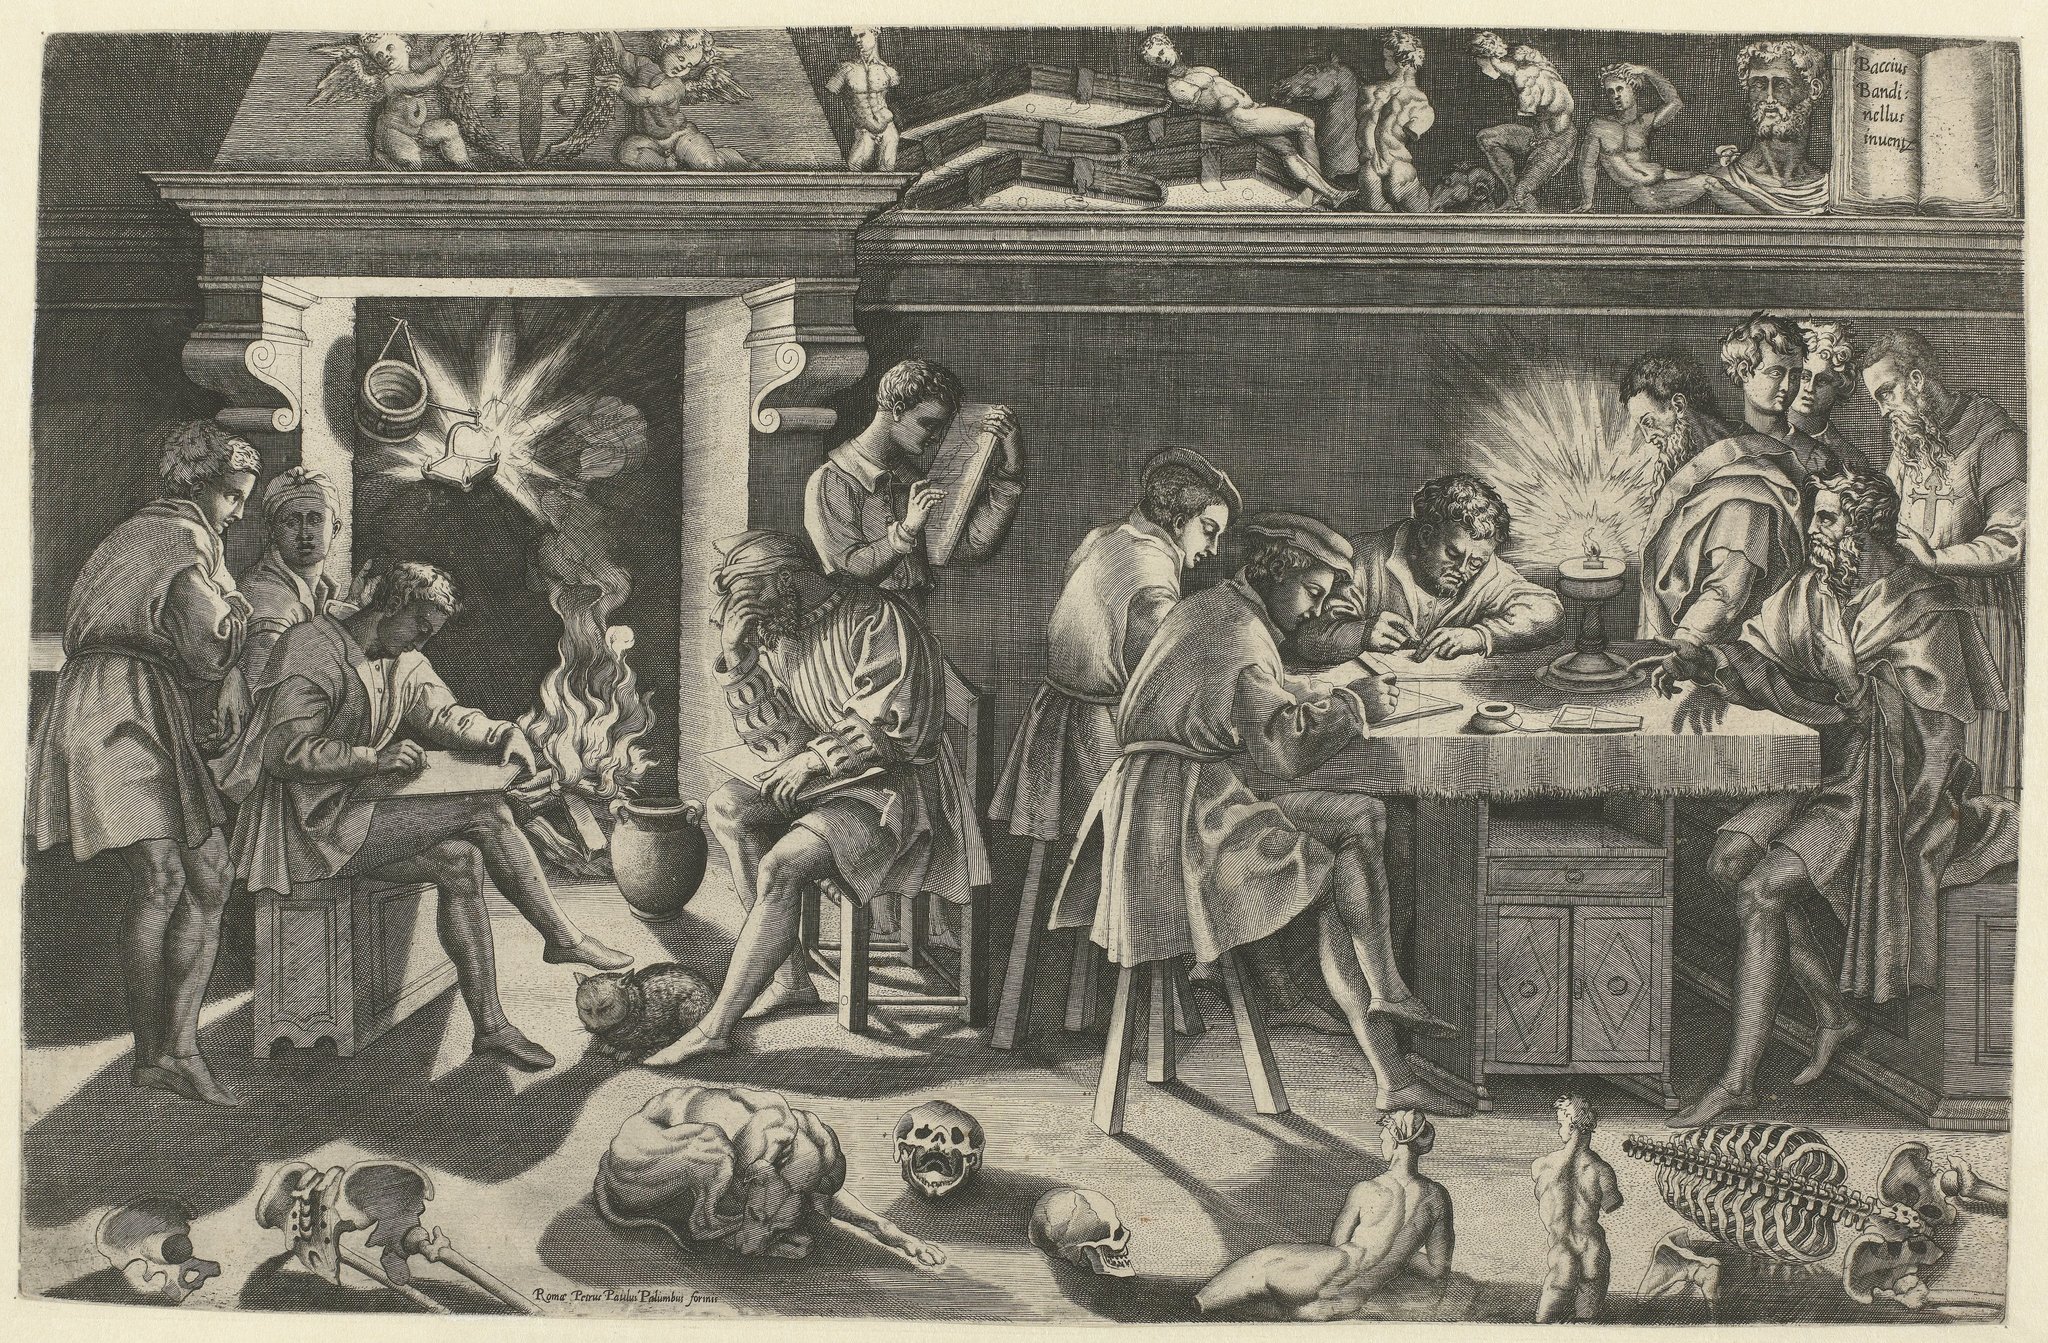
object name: print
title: The Academy of Baccio Bandinelli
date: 1533-1567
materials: paper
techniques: engraving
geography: italy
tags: piece of sculpture, reproduction of a piece of sculpture, candle, student, draughtsman studying classical remains, place or institution of education and training of the artist, e.g.: academy of art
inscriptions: collector's mark: Lugt 240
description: Around 1540, the Florentine sculptor Bandinelli established a small drawing academy in his home, where young artists were taught disegno (the concept of drawn design). In addition to human skeletons, models made of plaster, wax, or terracotta played a major role in drawing instruction. A small torso strongly resembling the modello by Van der Schardt on view here can be seen on the right of the mantelpiece.